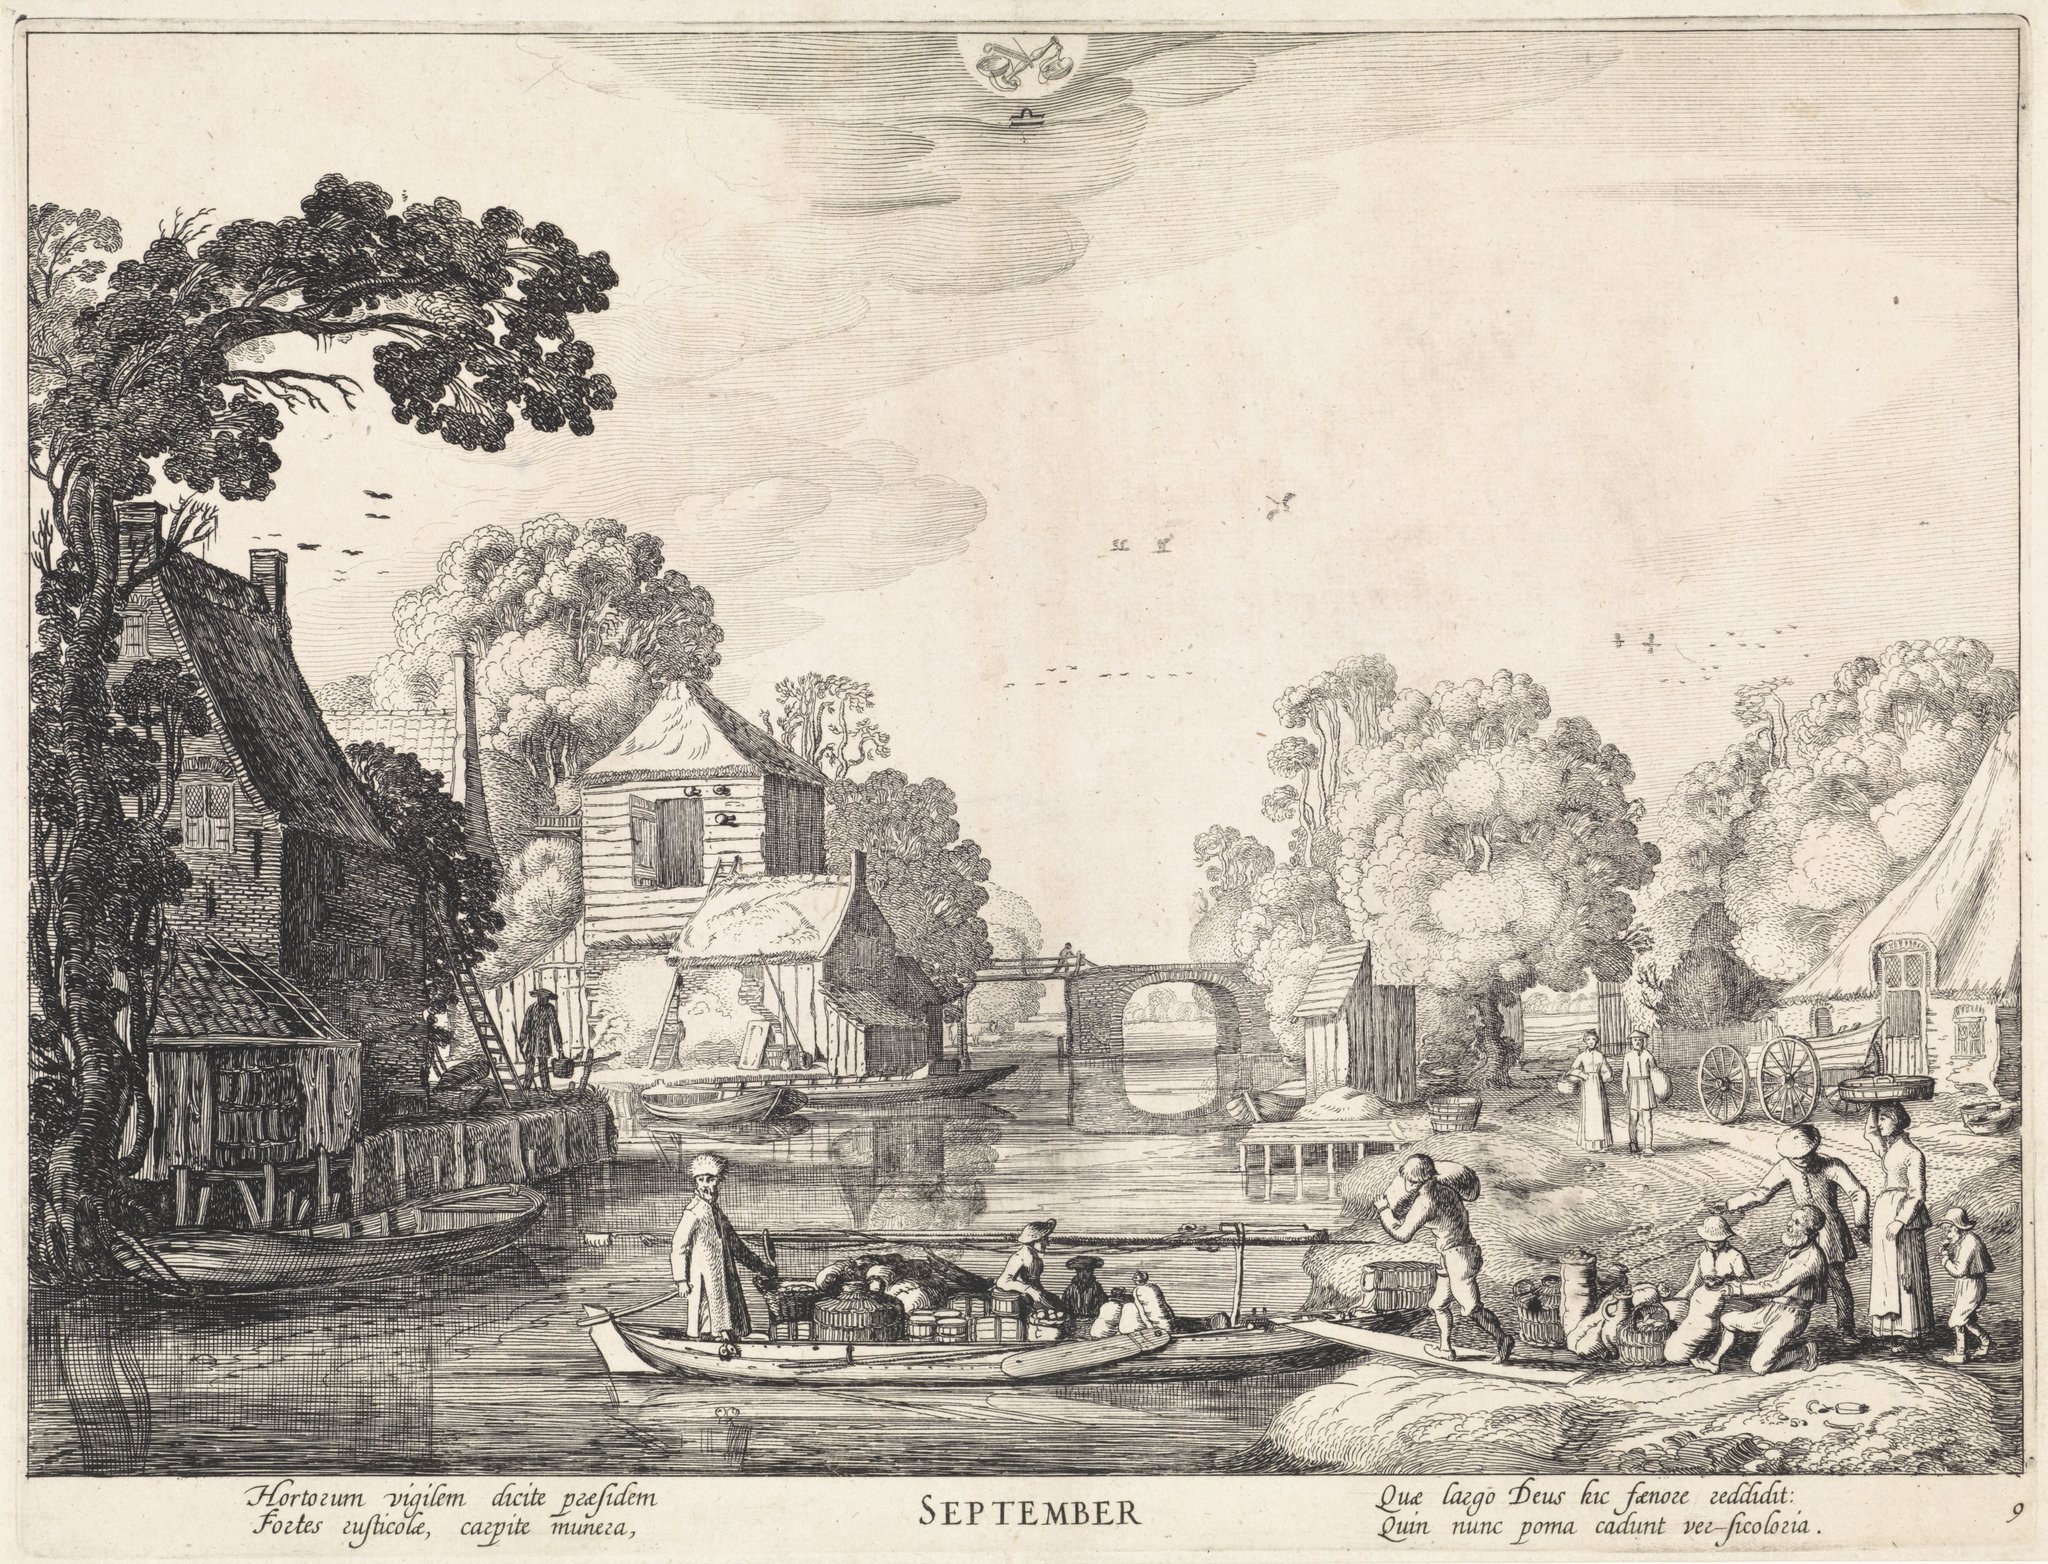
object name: print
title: De twaalf maanden, met dorpsgezichten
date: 1618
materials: paper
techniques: etching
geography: northern netherlands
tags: landscape symbolizing september, september and its 'labours', canals, waters (in village), libra (zodiacal sign of september), ferry, traffic on the water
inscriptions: collector's mark: Lugt 964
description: Gezicht op een dorp aan een rivier, waarop een boot wordt ingeladen met manden en zakken; een dorp tussen Woerden en Alphen aan de Rijn, voorstellende de maand september. Bovenaan het bij deze maand behorende sterrenbeeld: weegschaal. Negende prent uit een serie van twaalf.